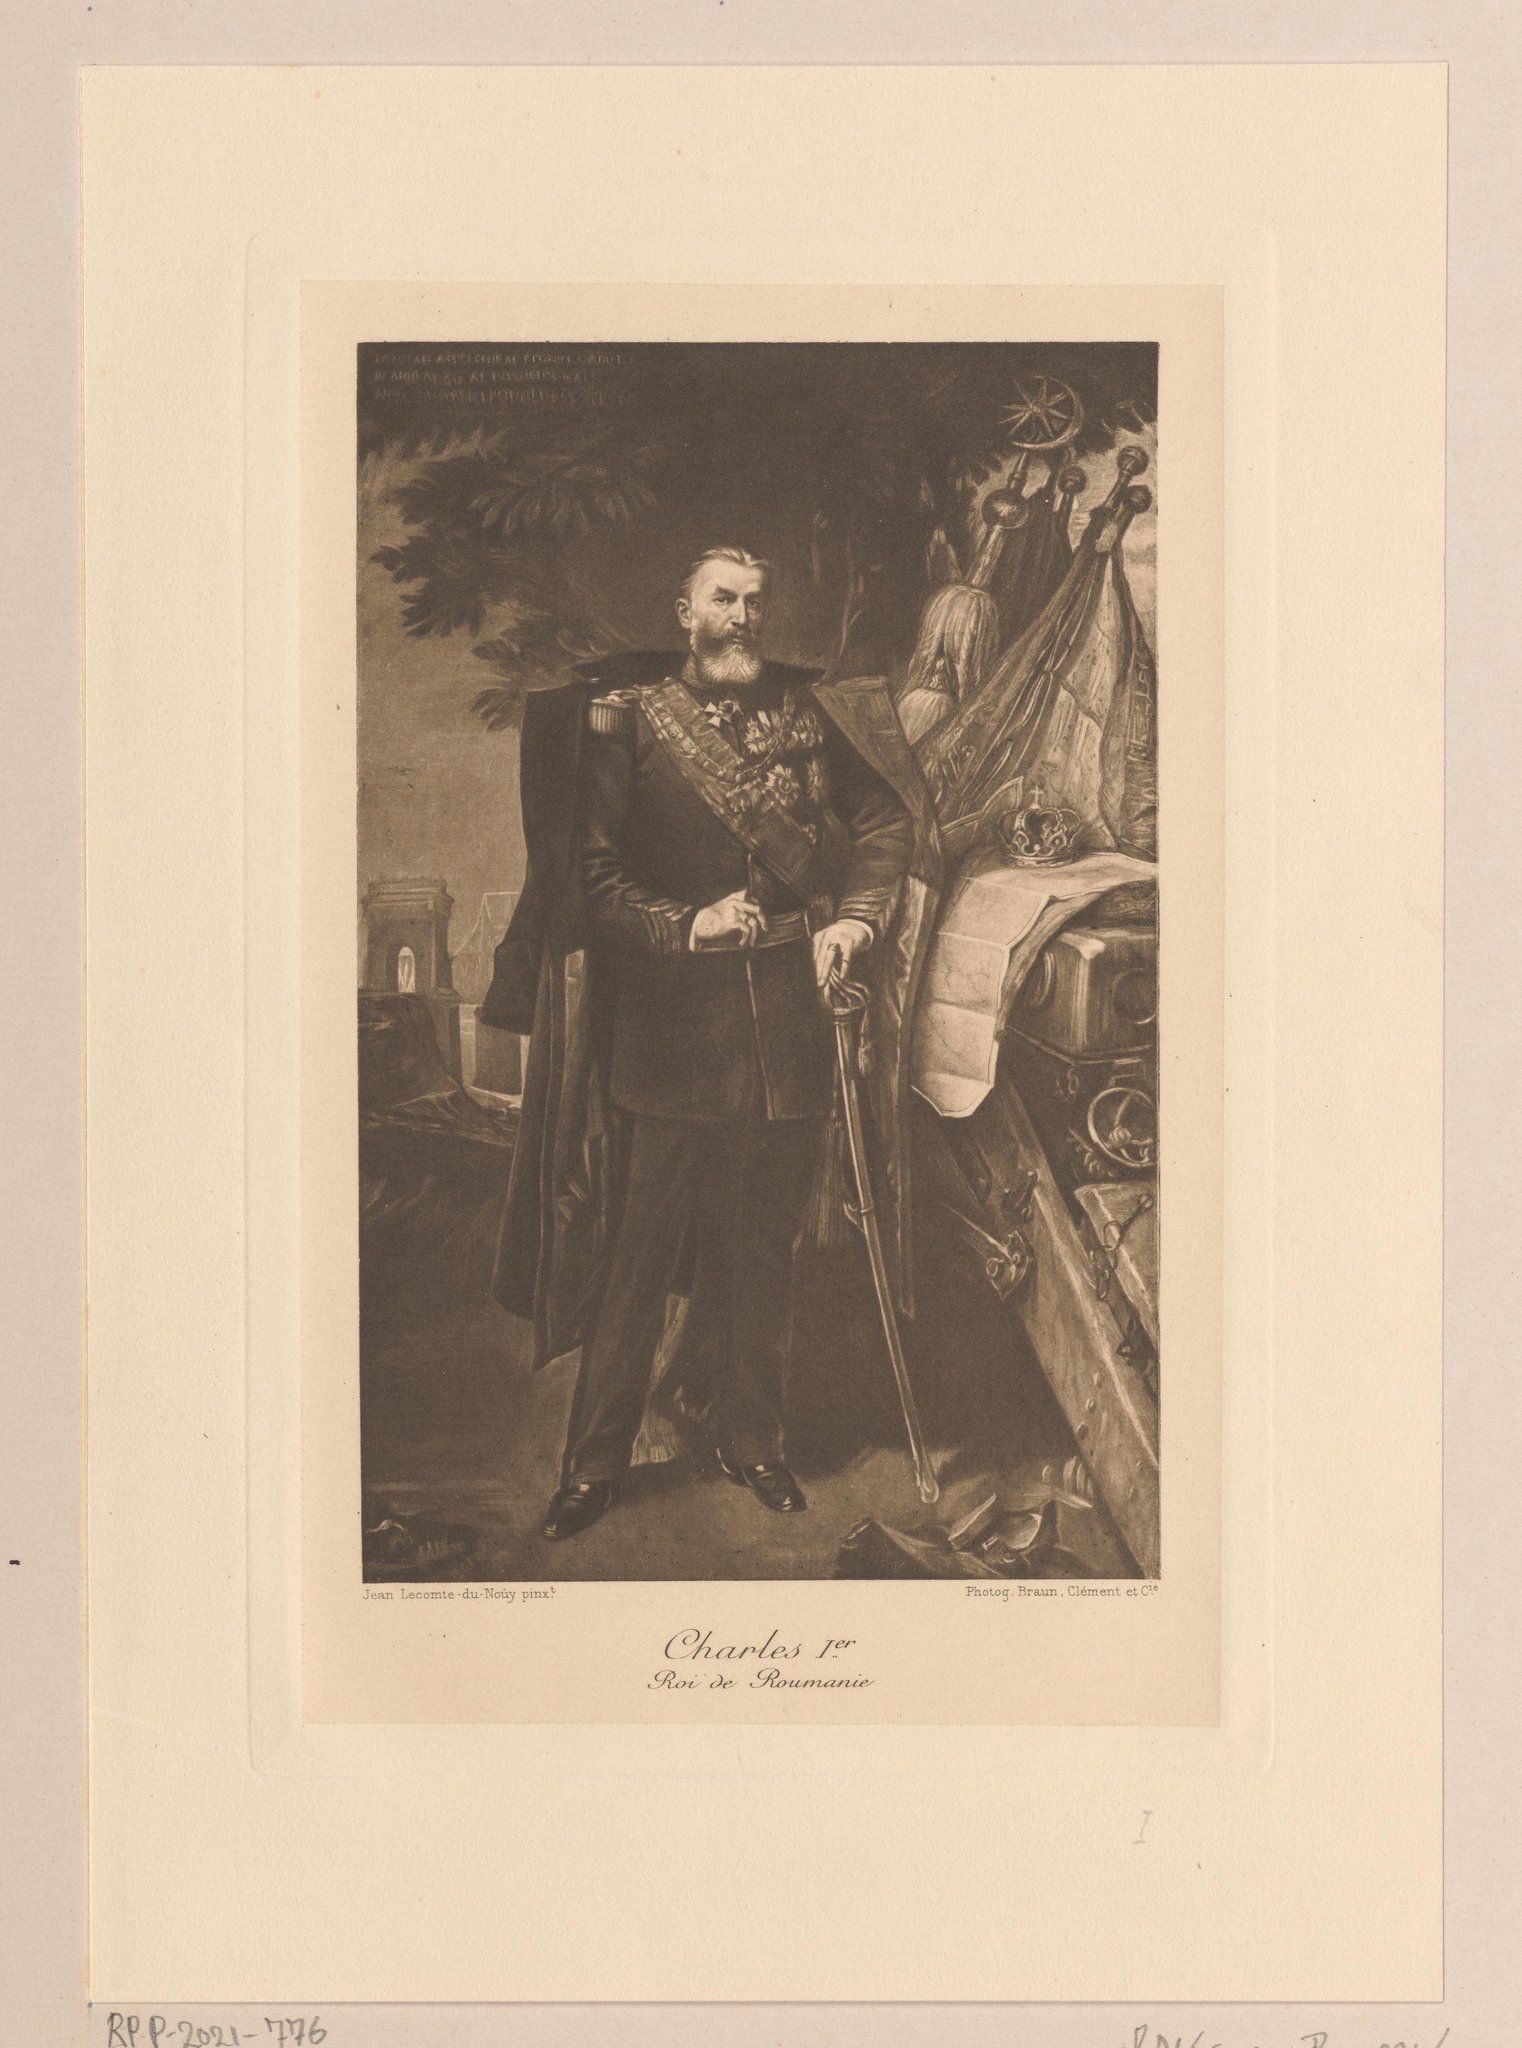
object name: photomechanical print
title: Portret van Carol I, koning van Roemenië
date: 1881-1900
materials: paper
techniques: blind stamped, photograph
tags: historical persons, king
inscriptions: collector's mark: ‘F.G.W.’